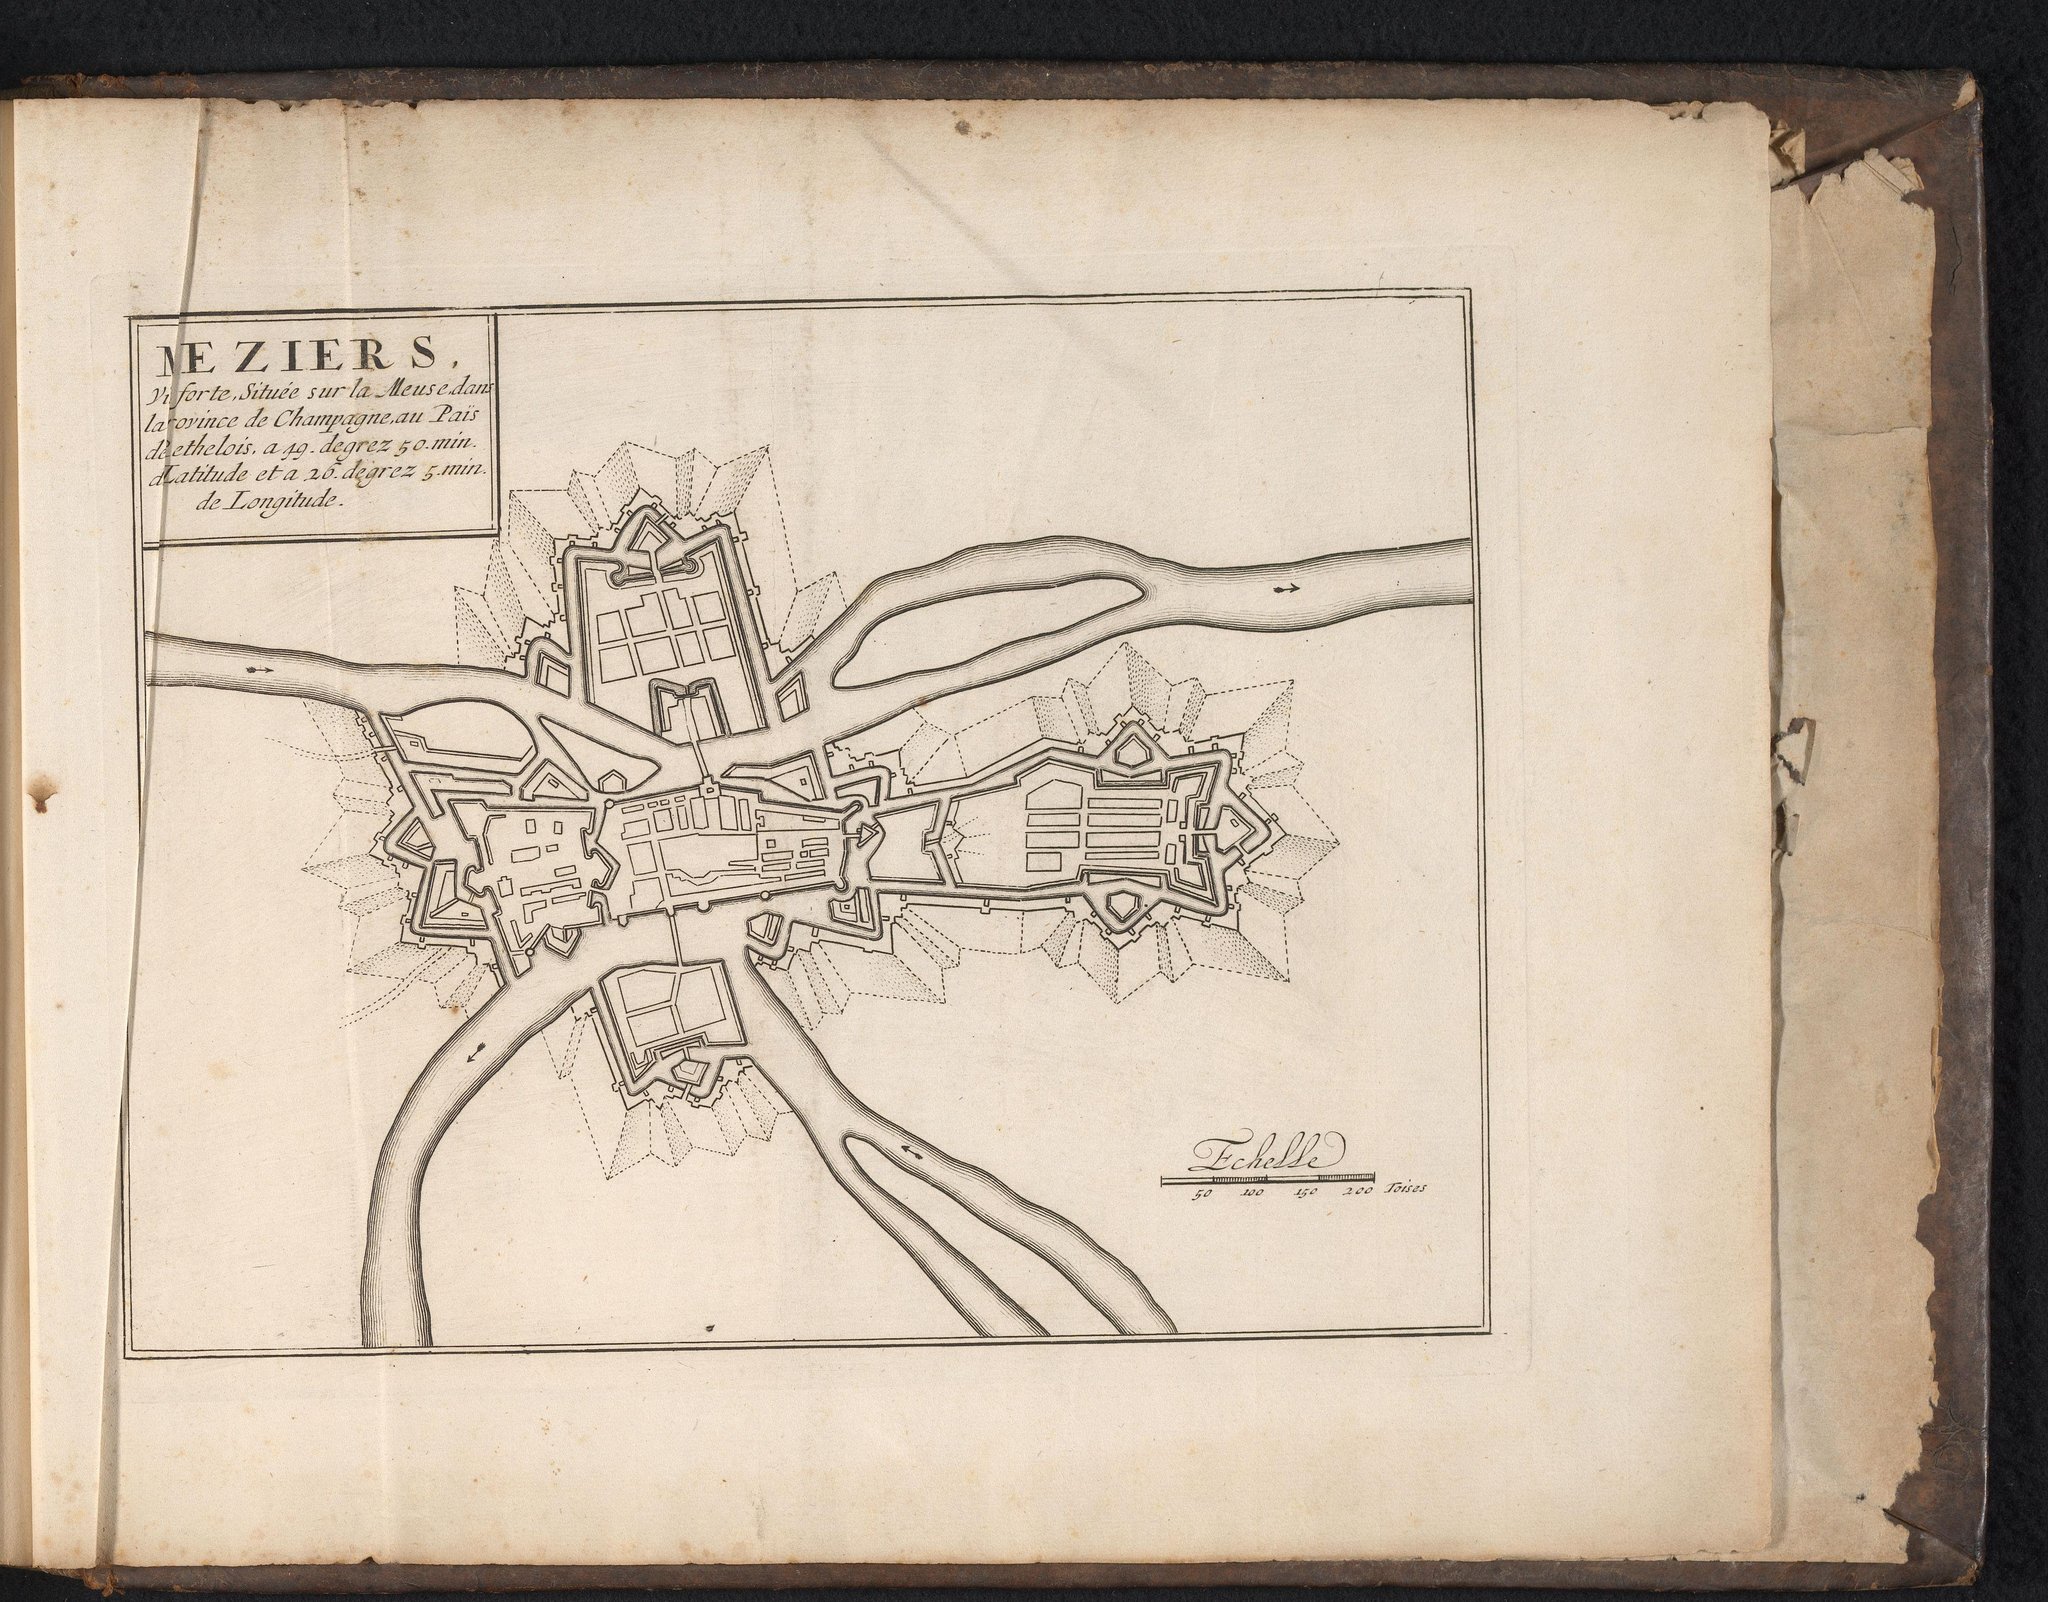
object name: print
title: Plattegrond van Mézières, ca. 1693-1696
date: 1693-1696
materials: paper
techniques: etching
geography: paris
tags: fortress, maps of cities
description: Plattegrond van de versterkingen om de Franse stad Mézières (Charleville-Mézières). Onderdeel van het tweede van twee delen van het prentwerk: Le Theatre de la Guerre, dans les Pays-Bas, waarvan het titelblad uitgegeven is in 1696. Het prentwerk bestaat in totaal (beide delen) uit 52 platen met plannen (afkomstig van Sébastien Le Prestre, Seigneur de Vauban) van vermaarde sterke steden en vestingen in de Negenjarige Oorlog in de Nederlanden. Identiek aan de plaat die voorkomt in: Les forces de l'Europe, uitgegeven tussen 1693-1697. Titel en opschriften in het Frans.